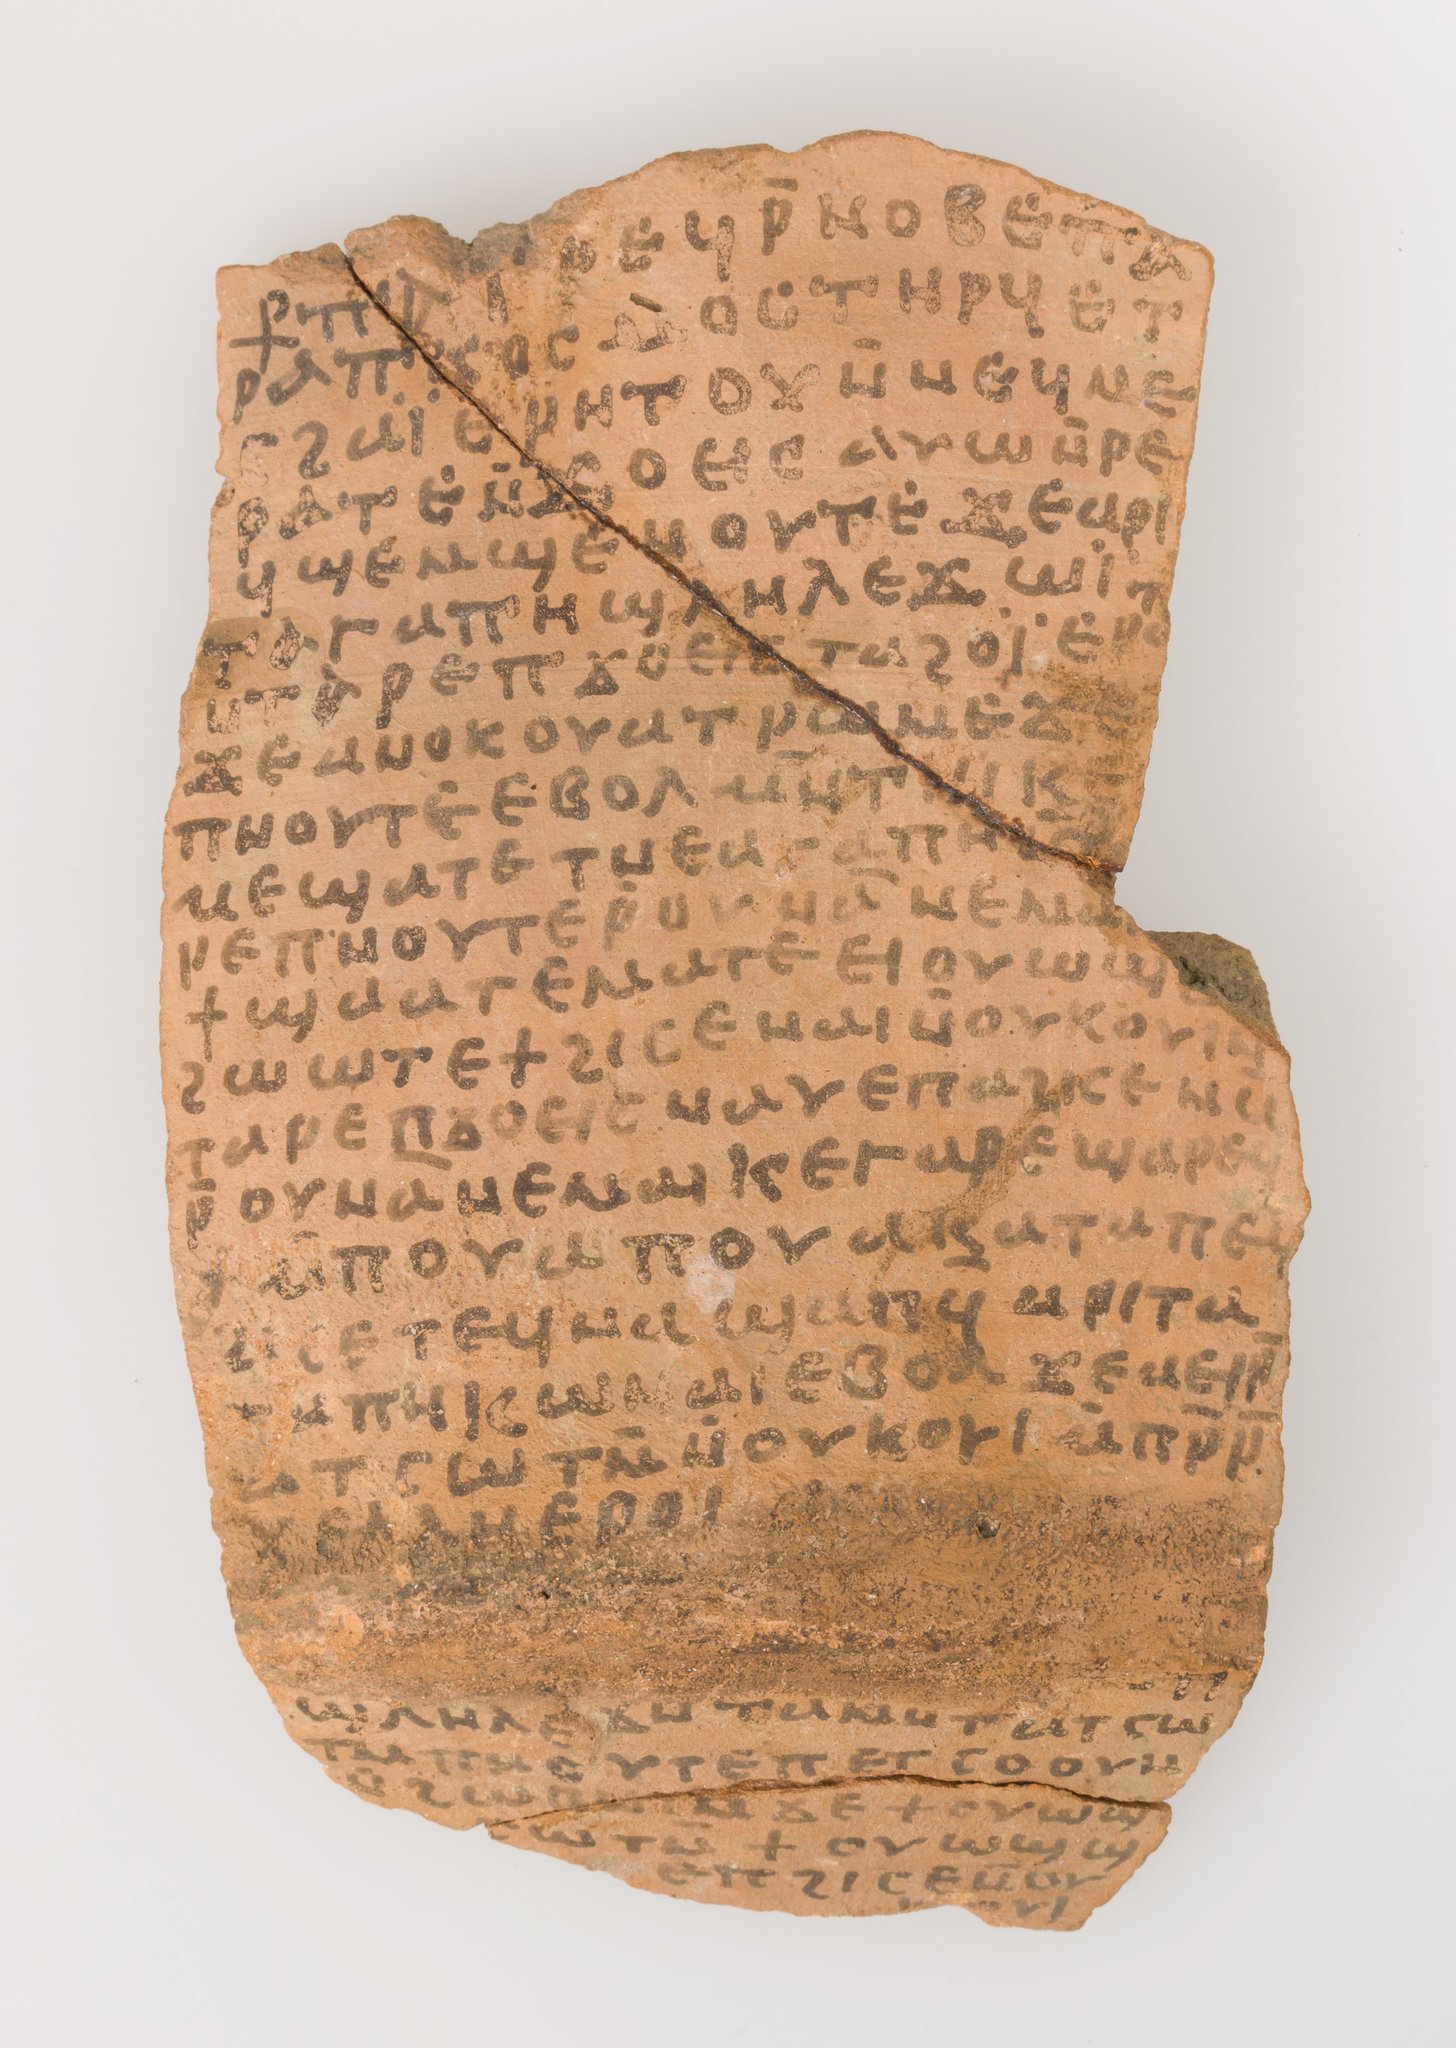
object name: ostrakon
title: Ostrakon with a Letter from Joseph to—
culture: coptic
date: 580-640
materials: ink, pottery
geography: egypt